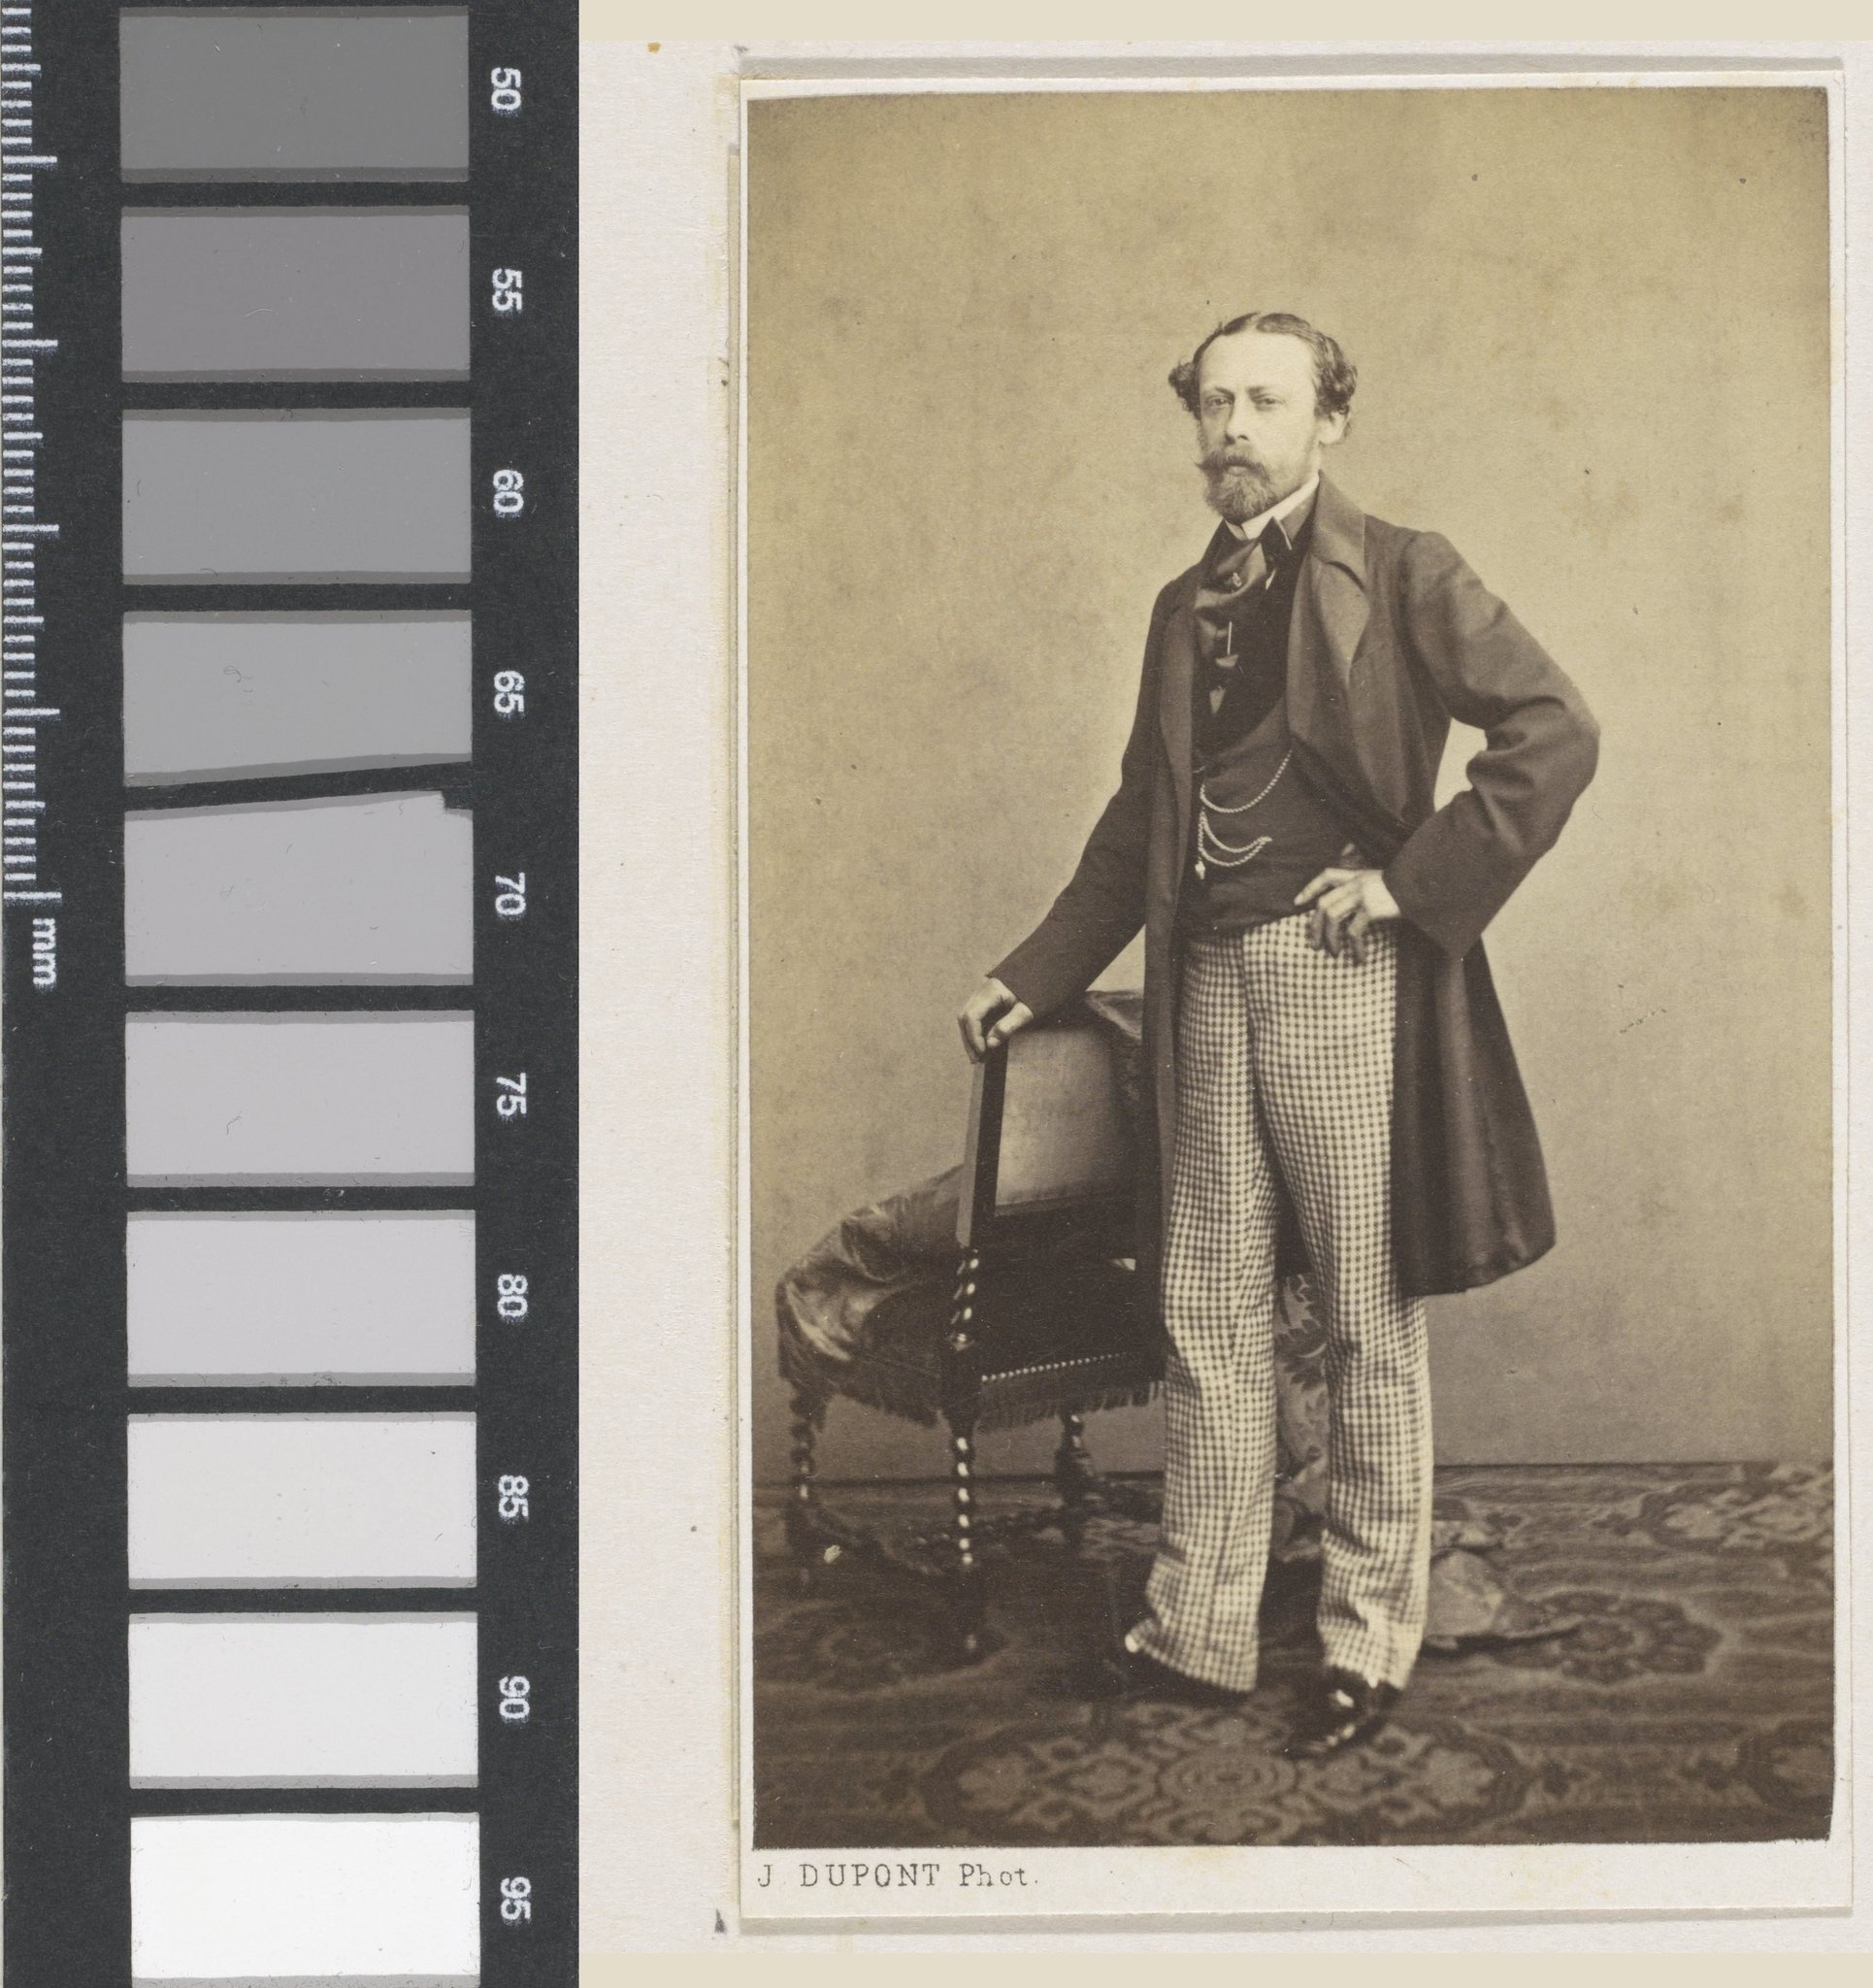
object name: photograph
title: Portret van de schilder Gustave Louis Marie Pieron, ten voeten uit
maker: joseph dupont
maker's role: fotograaf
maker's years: 1818-1901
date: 1861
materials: cardboard, paper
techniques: albumen print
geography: antwerp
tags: antwerp, painter, historical persons, portrait, self-portrait of painter, portrait, self-portrait of artist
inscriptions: inscription: ‘ETABLISSEMENT PHOTOGRAPHIQUE/ de/ J. DUPONT/ Place de Meir 32/ ANVERS/ Maison fondée en 1853’